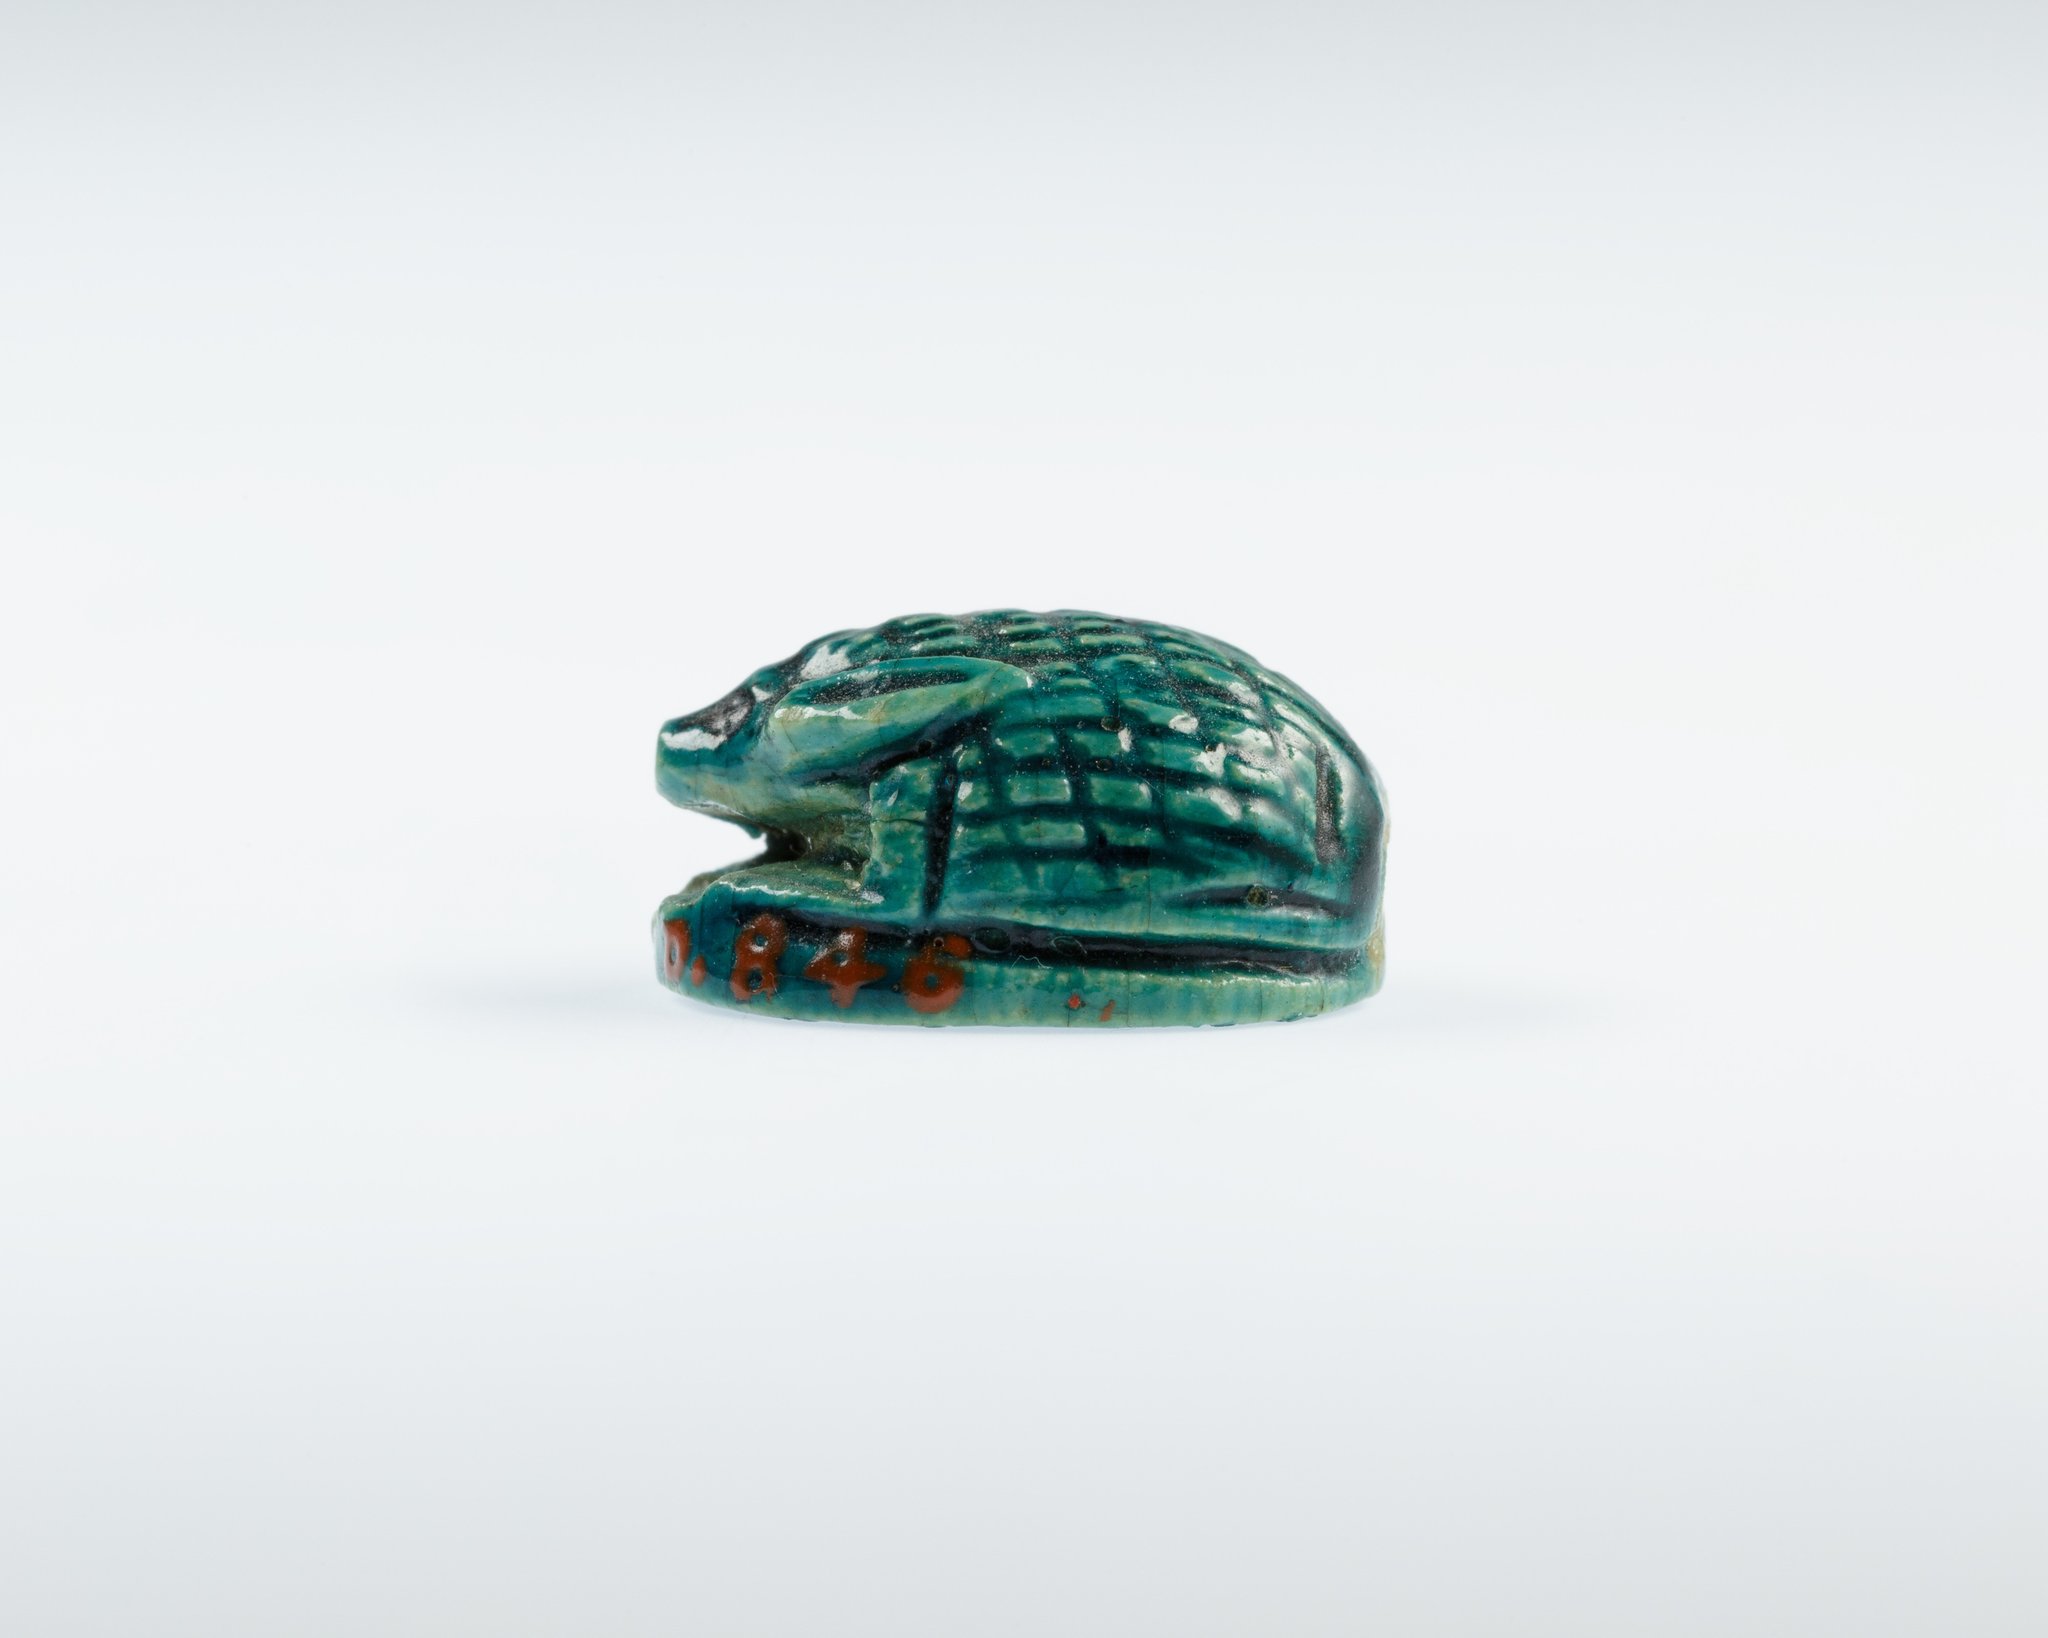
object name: seal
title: Hedgehog Seal with device of a horse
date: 1295-1185 BCE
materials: glaze, stone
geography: egypt